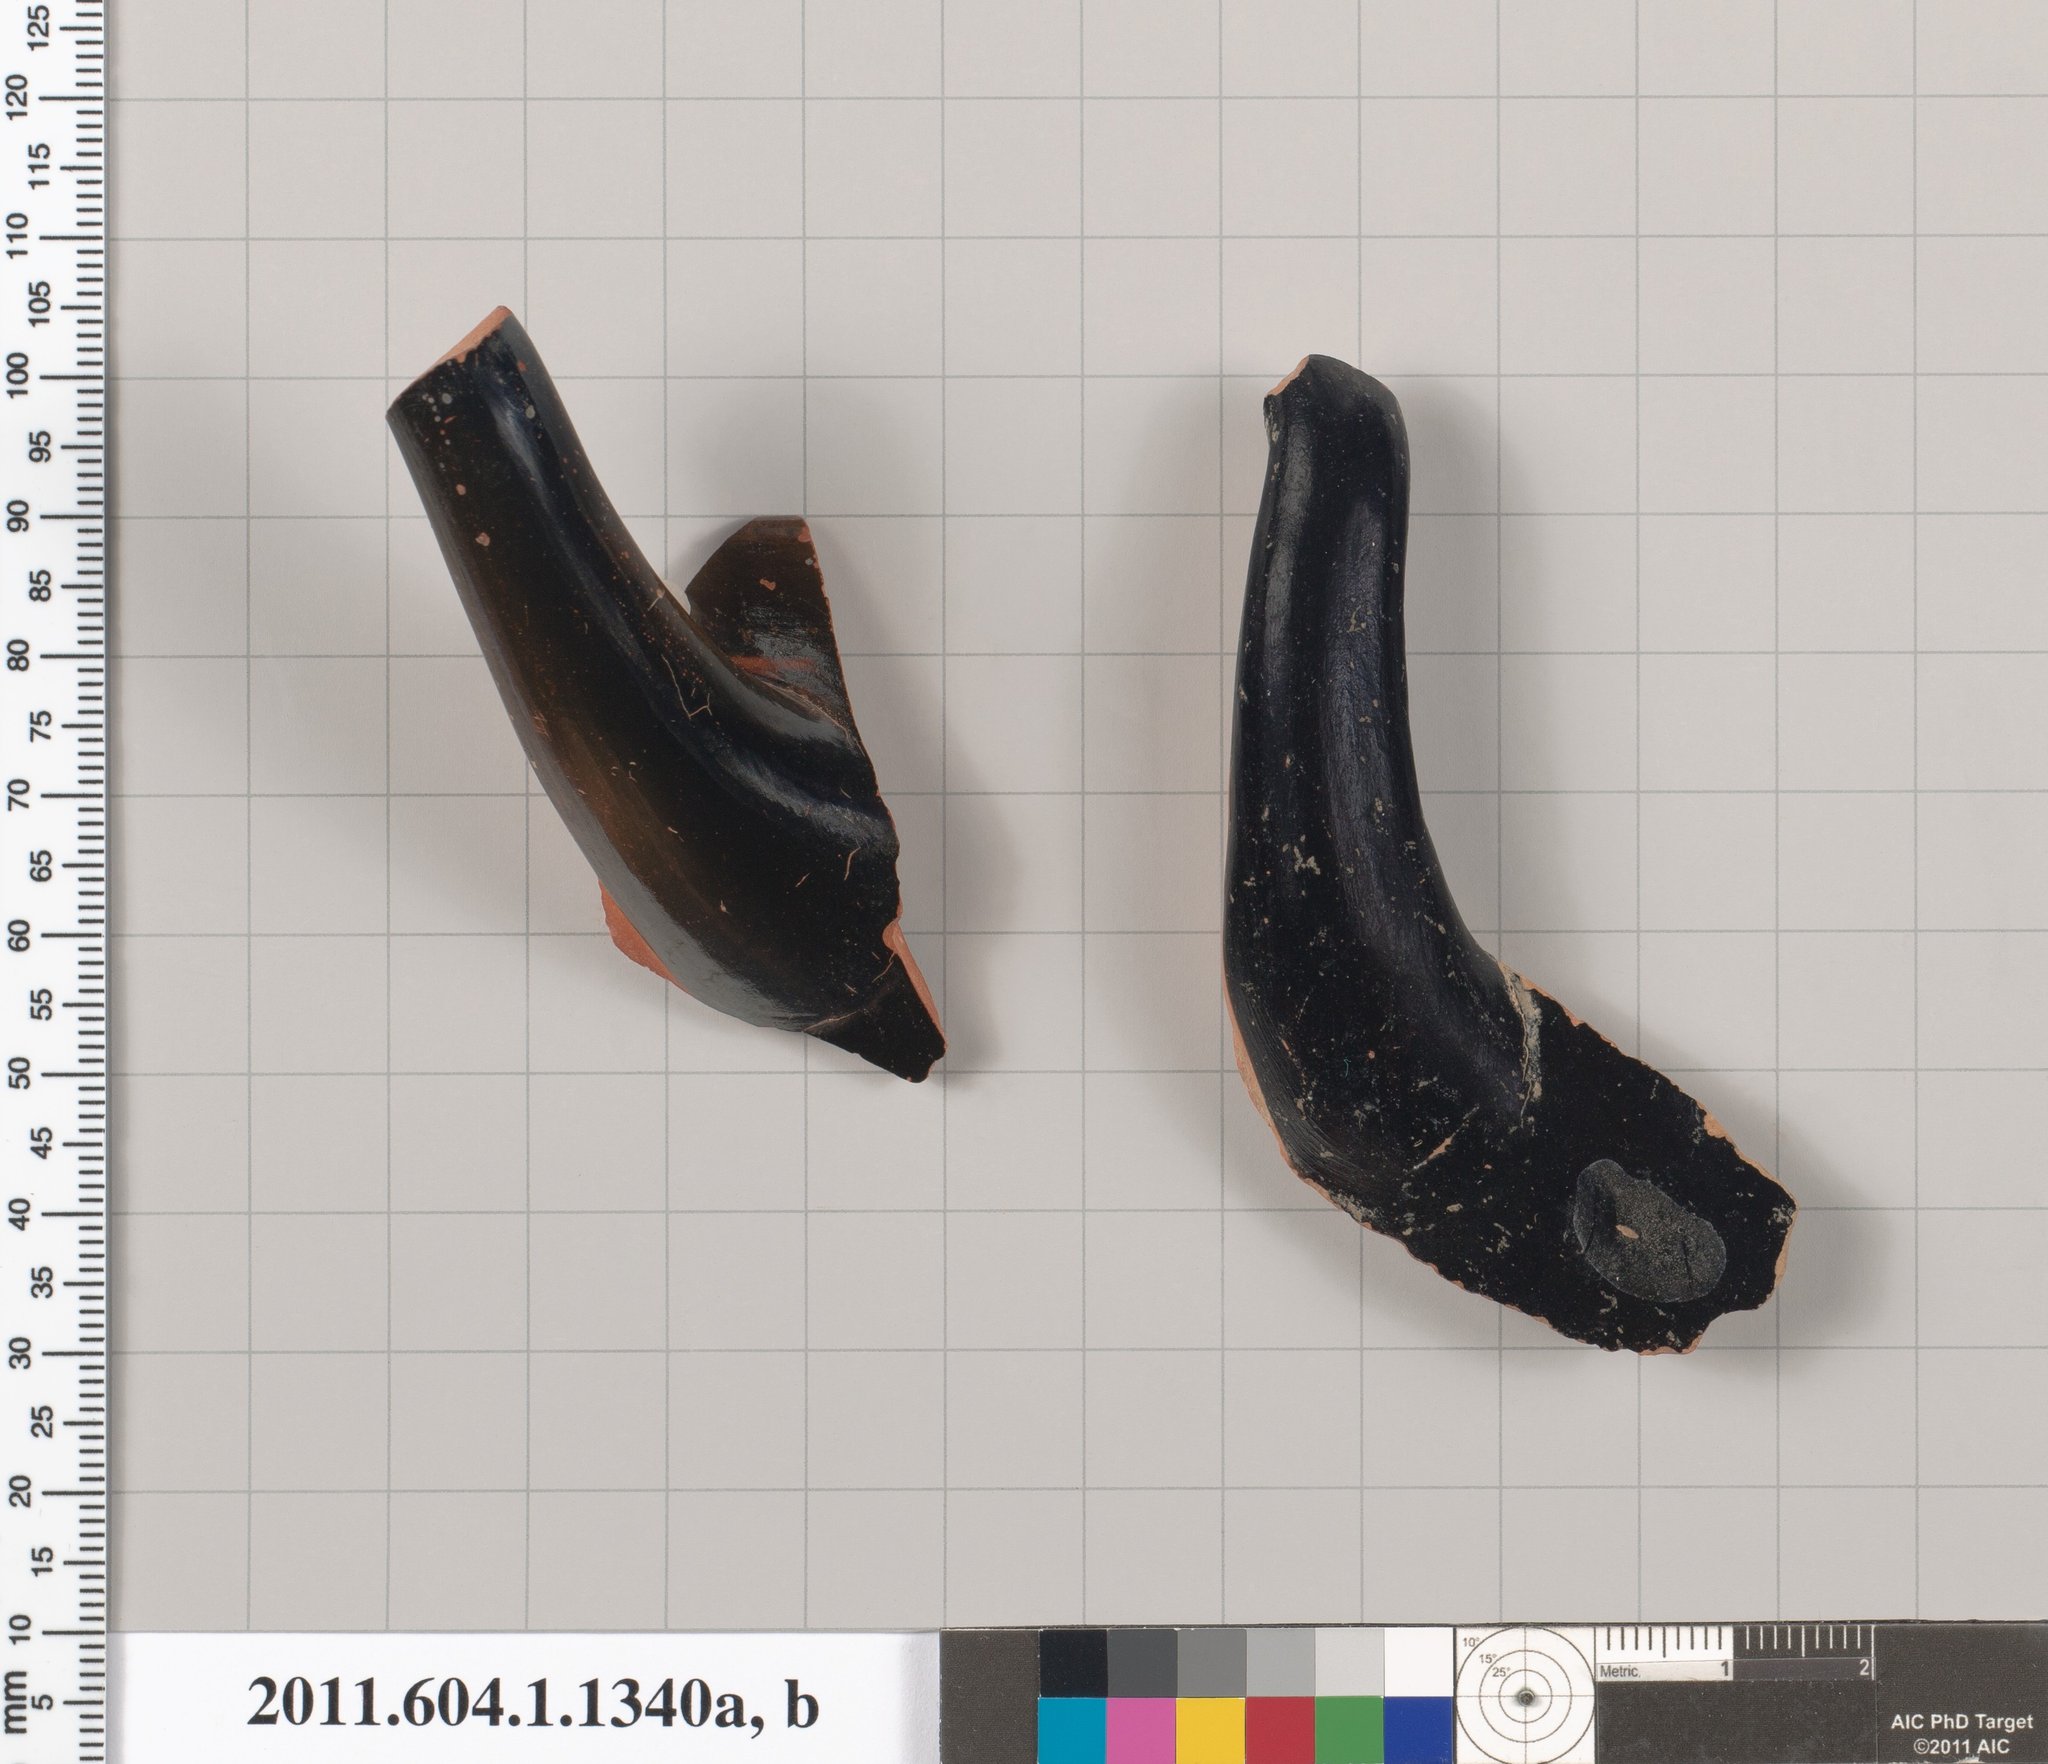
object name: kylix fragment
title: Terracotta fragments of kylikes (drinking cups)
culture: greek, attic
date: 500-401 BCE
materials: terracotta